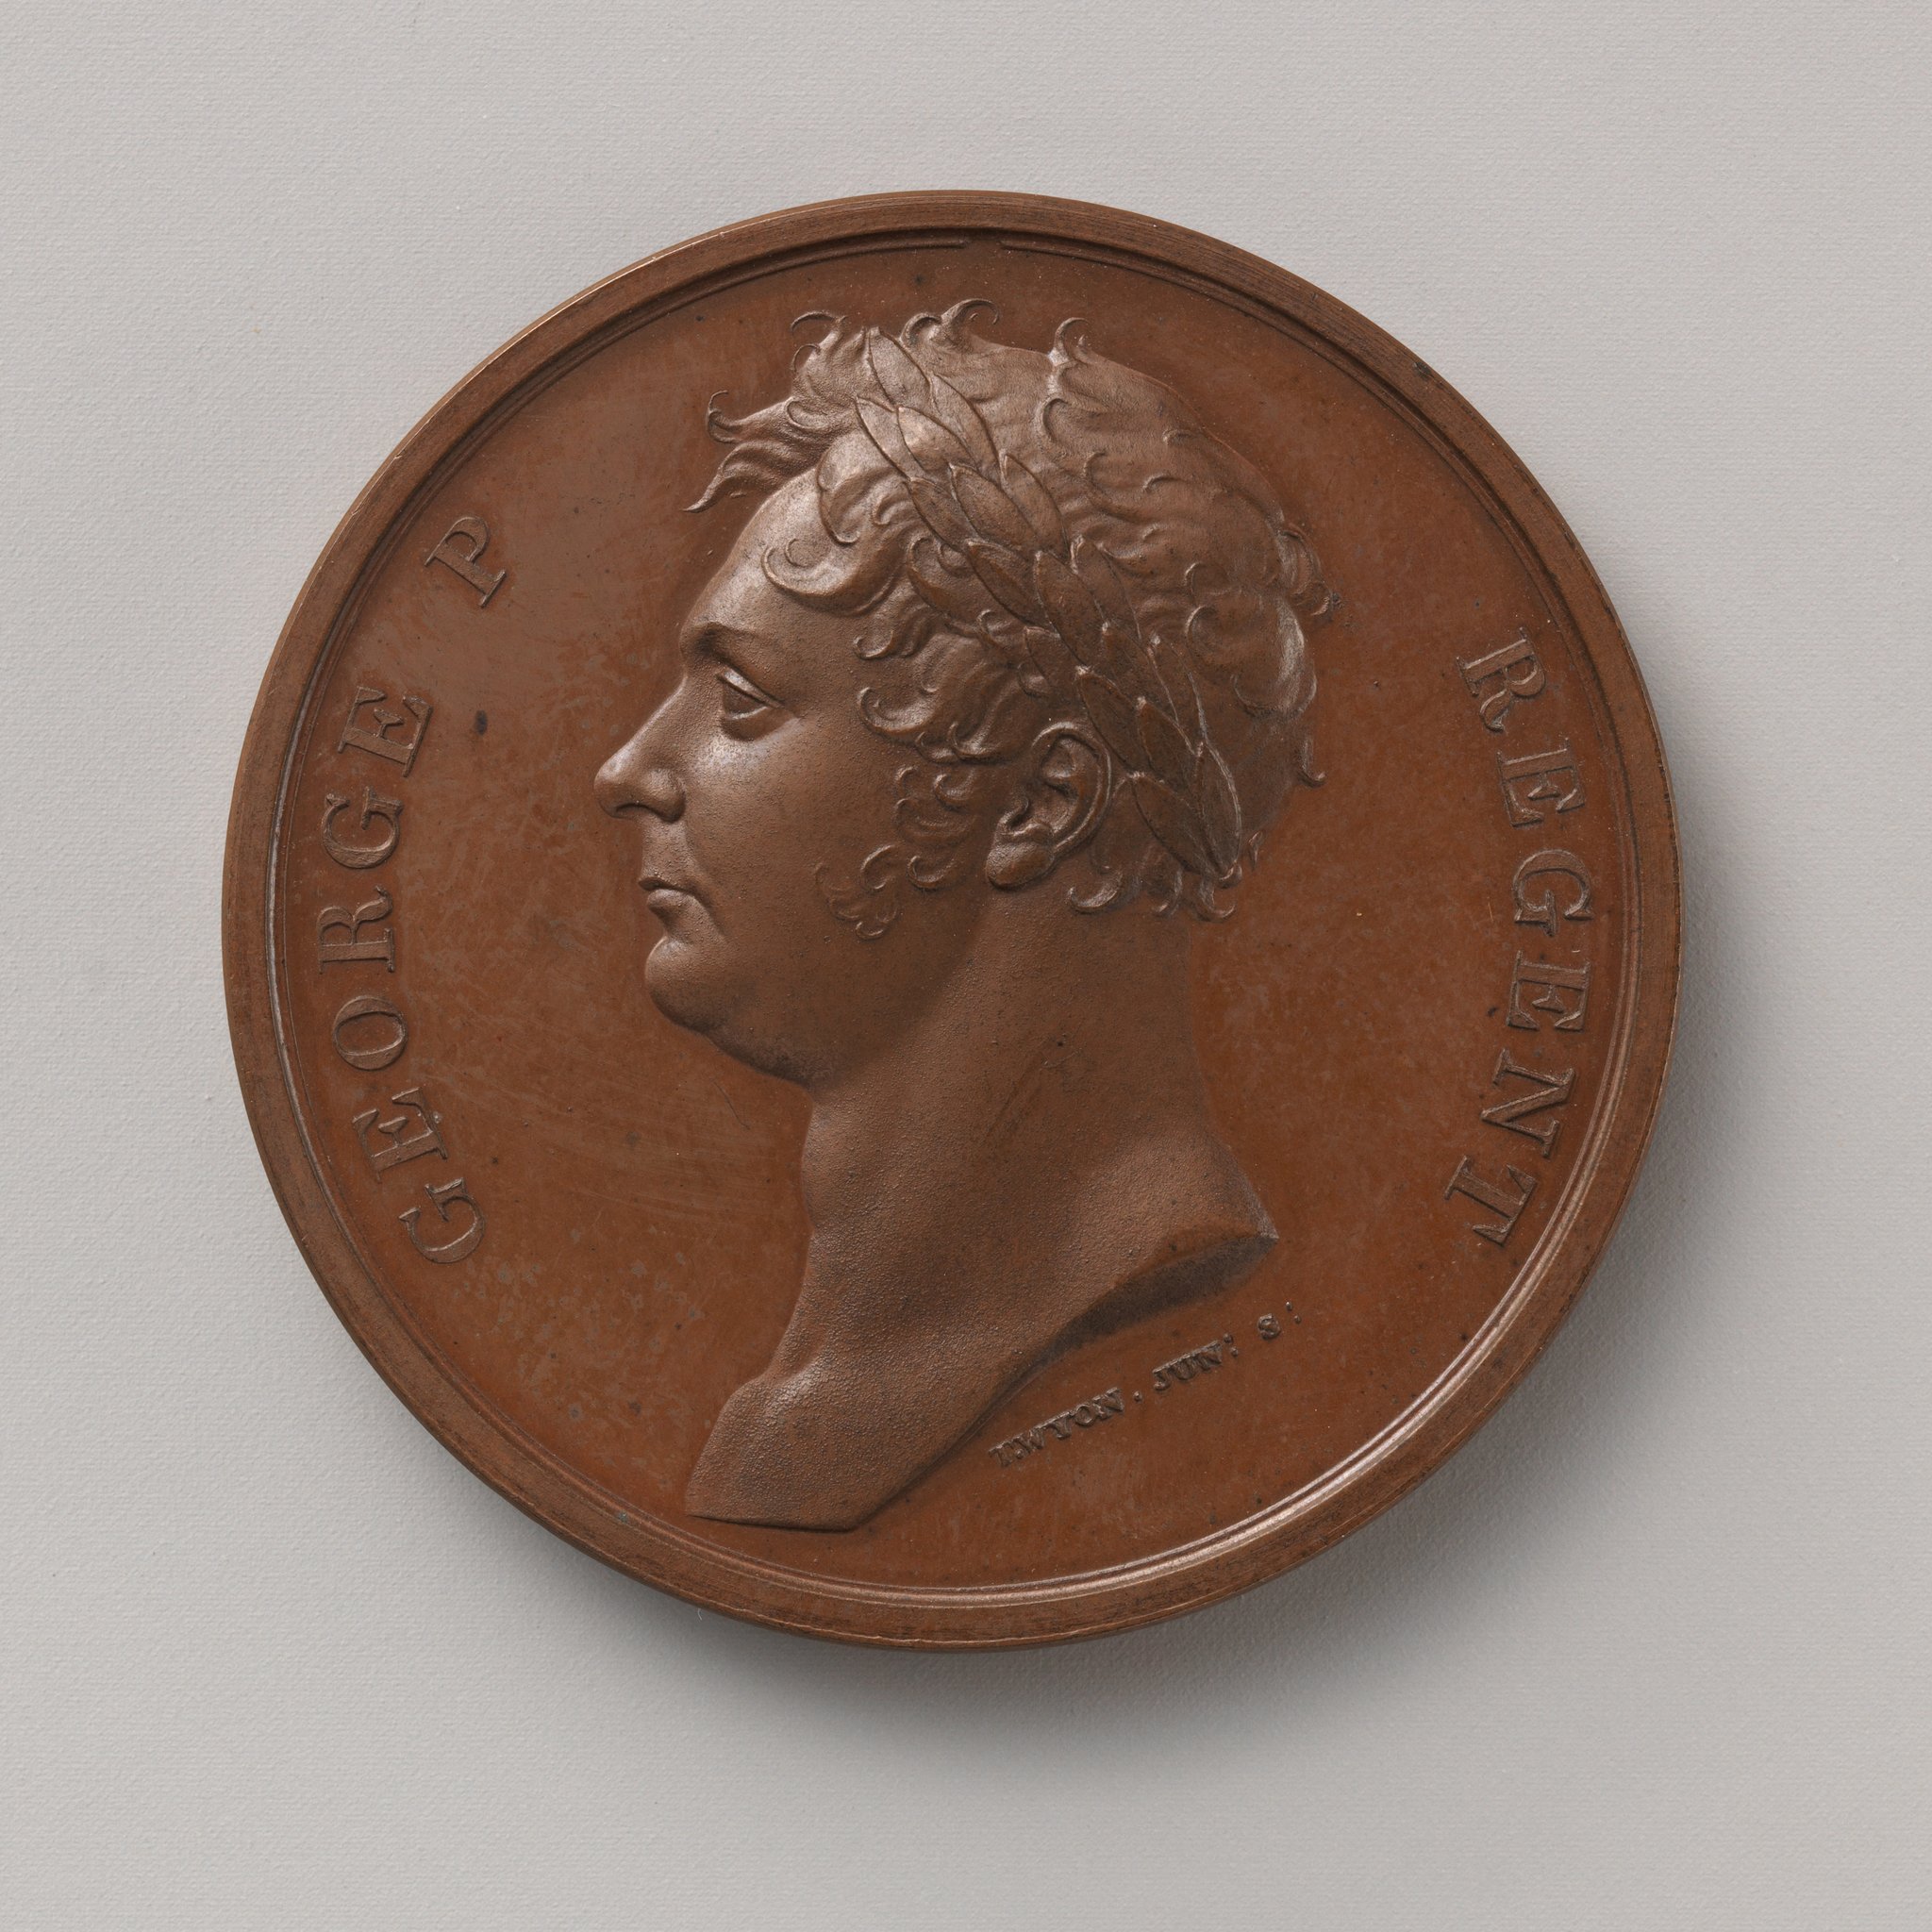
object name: medal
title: The Waterloo Medal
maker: thomas wyon the younger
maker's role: artist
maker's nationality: british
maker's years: 1791-1817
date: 1815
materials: bronze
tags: men,profiles,fairies,flowers